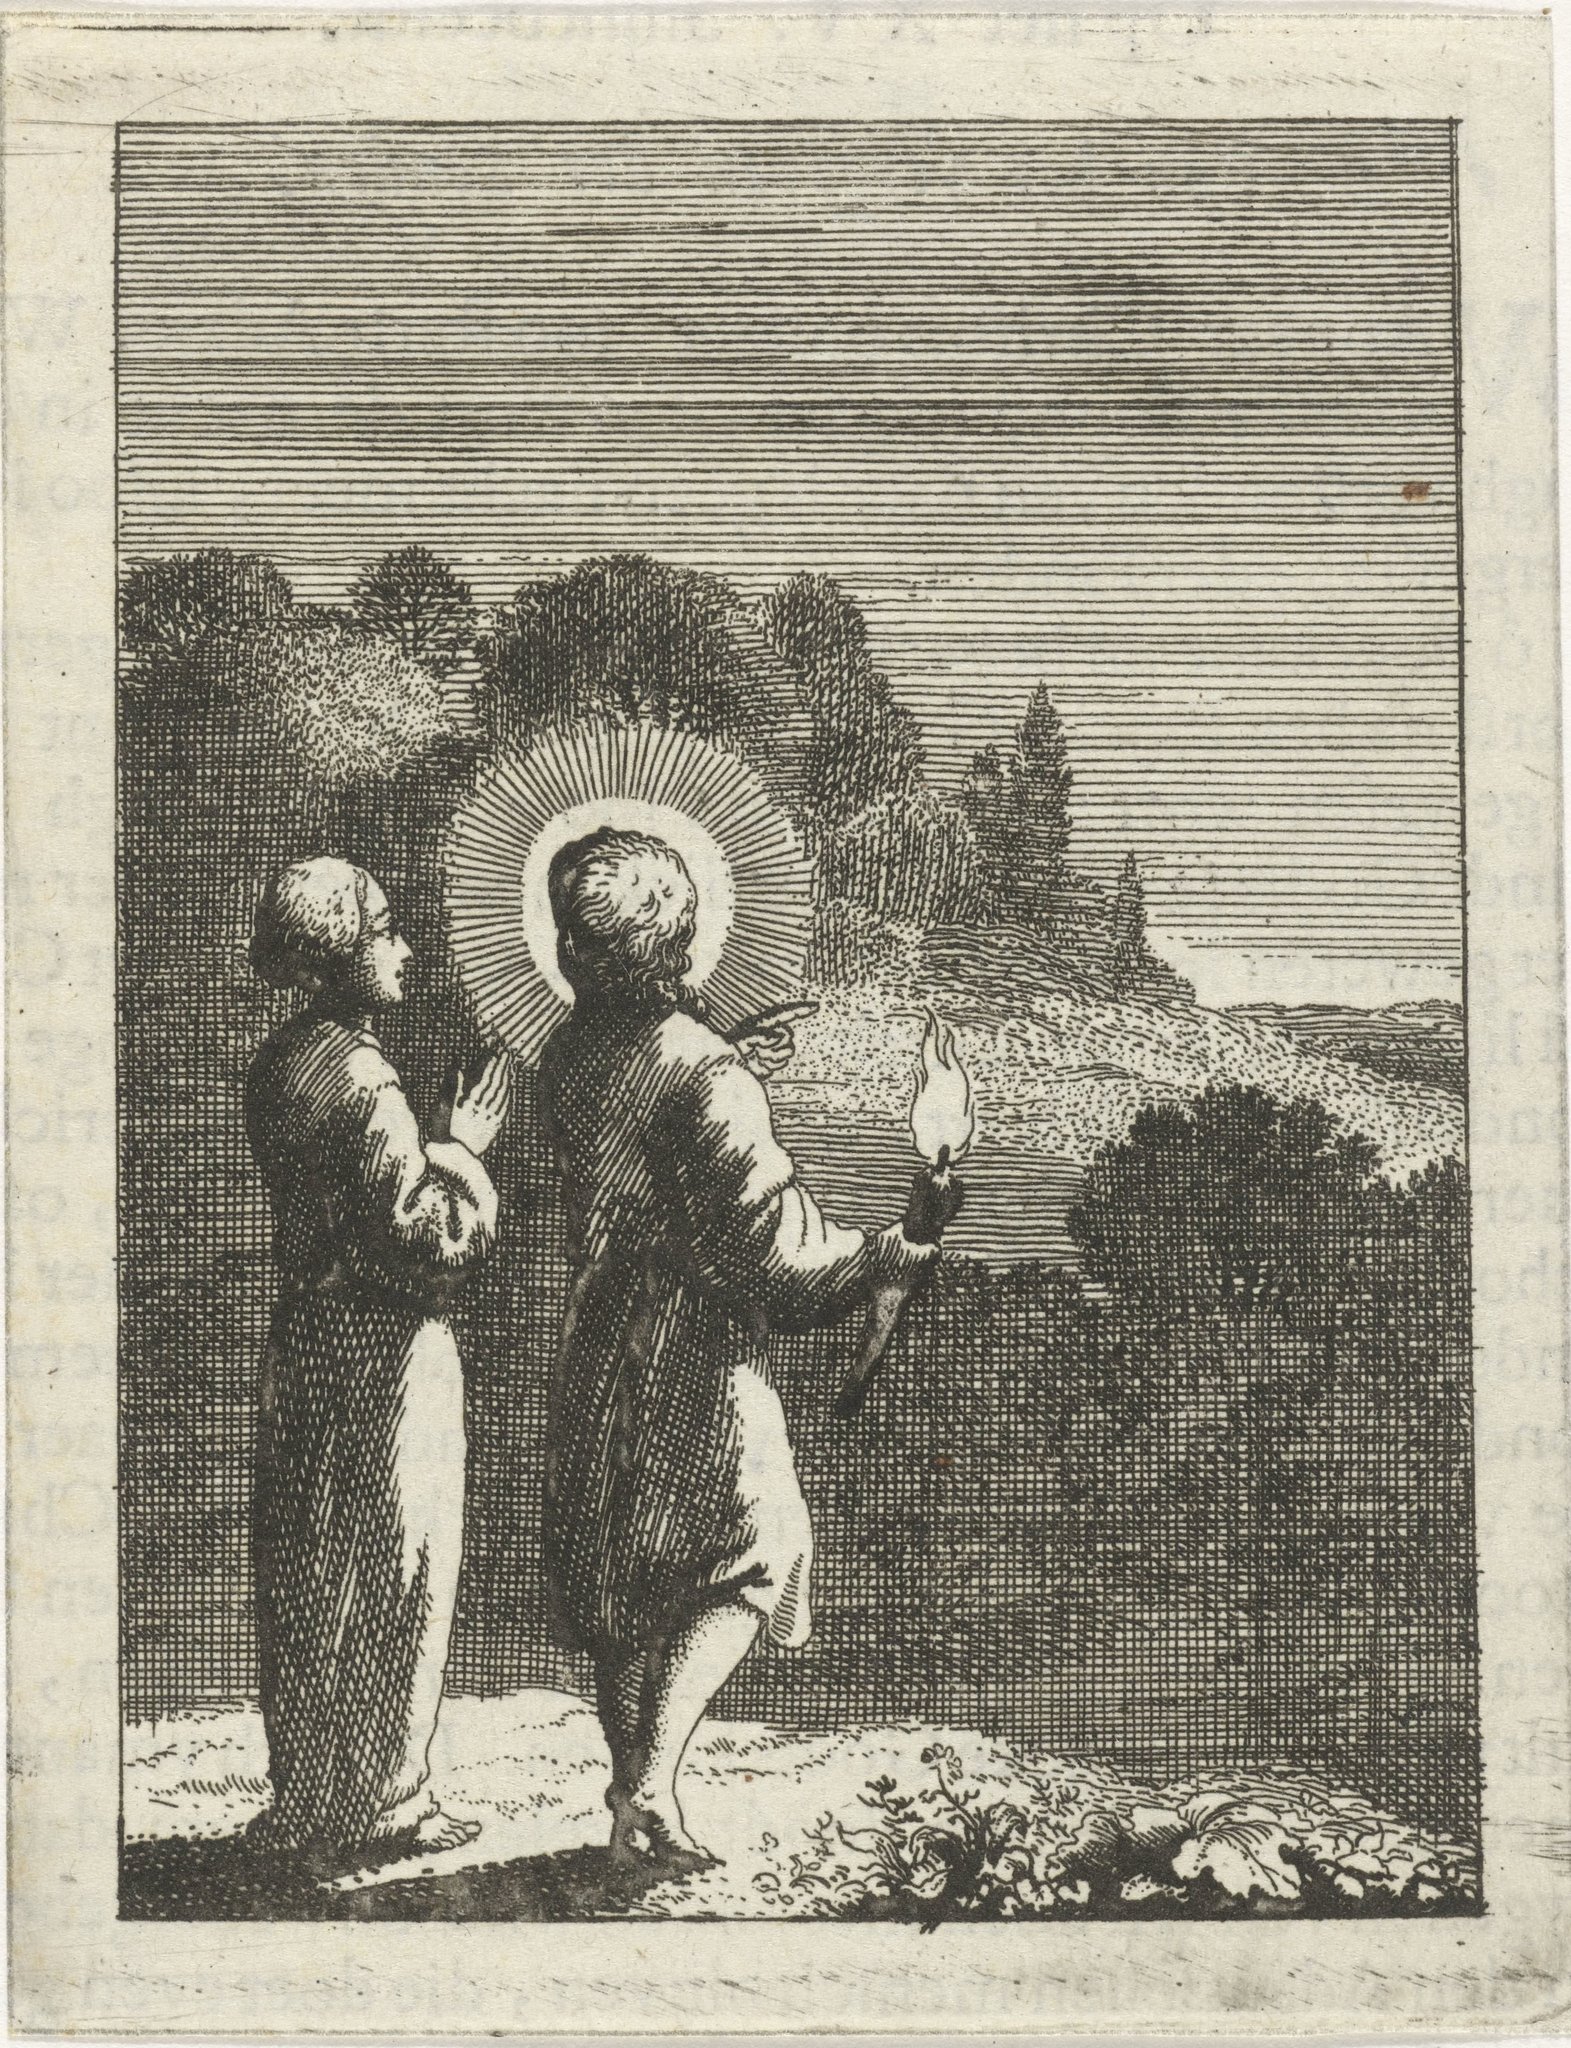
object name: book illustration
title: Christus verlicht voor de gepersonifieerde ziel de duisternis met een fakkel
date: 1678-1687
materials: paper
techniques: etching, letterpress printing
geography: amsterdam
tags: darkness, christ and the soul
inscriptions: collector's mark: Lugt 2228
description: Illustratie uit: Luyken, Jan. Jezus en de Ziel, 3 delen. Amsterdam: Pieter Arentsz II, 1678-1687. Tussen 1678-1744 verschenen van dit emblemataboek 10 edities.